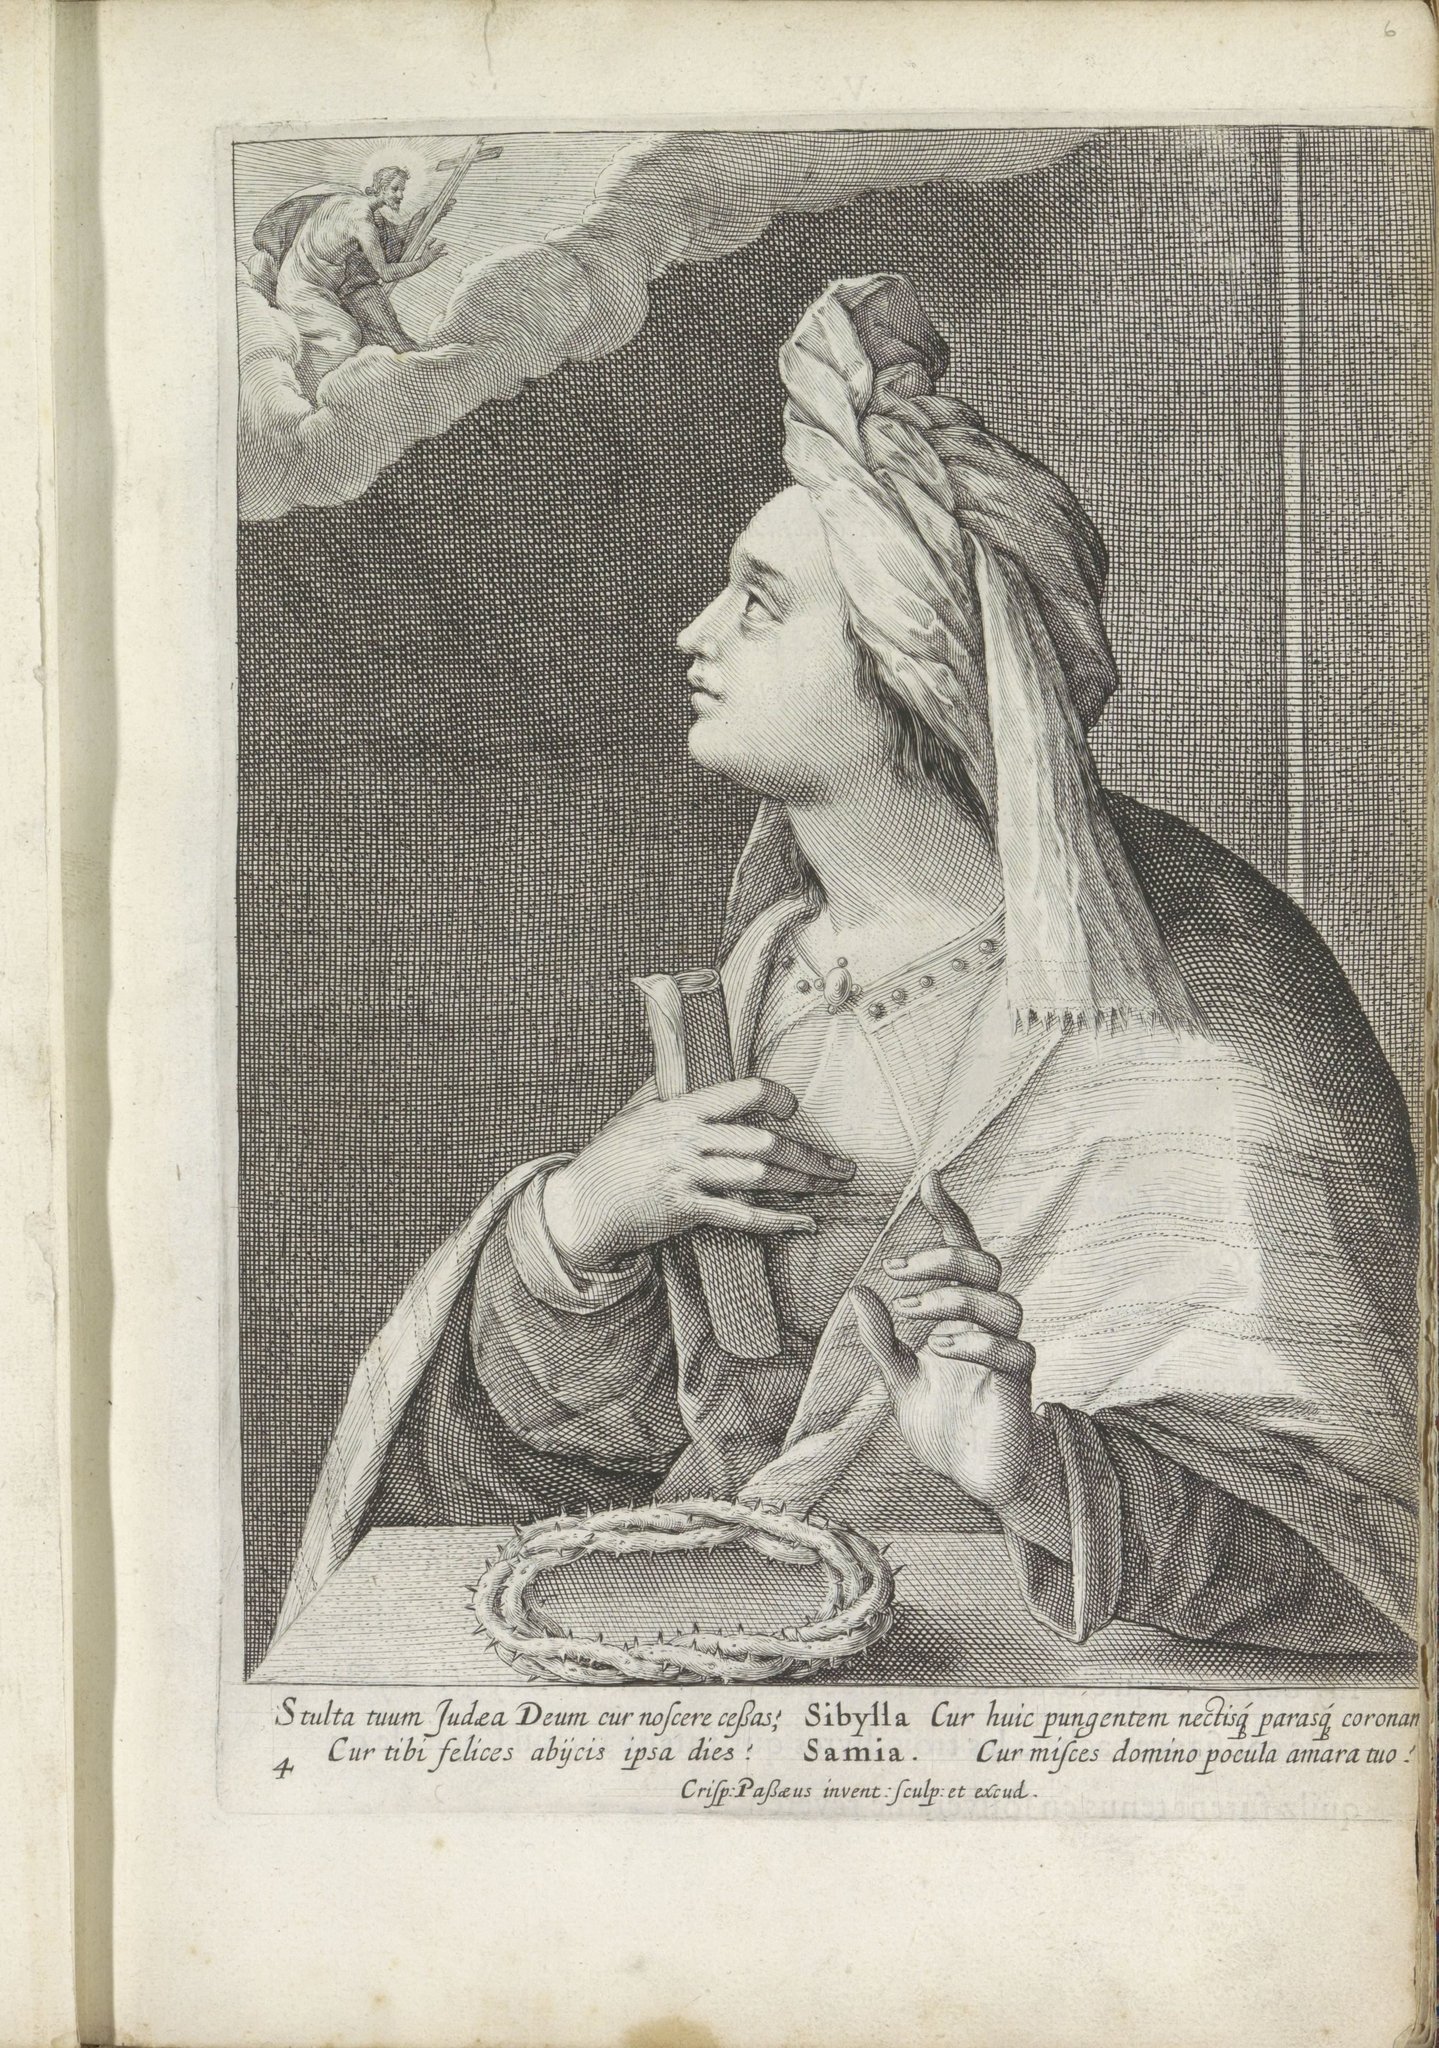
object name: album leaf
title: Sibille van Samos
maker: crispijn van de passe (i)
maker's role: draughtsman, print maker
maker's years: 1564-1637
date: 1615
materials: paper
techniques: engraving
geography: utrecht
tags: types of adult christ (alone), samian sibyl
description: De Sibille van Samos zit aan een tafel en kijkt op naar de hemel waar Christus met het kruis verschijnt. In haar rechterhand houdt ze een opgerold vel papier. Op de tafel ligt een doornenkroon. Onder de voorstelling een onderschrift in het Latijn. Deze prent maakt deel uit van een album.